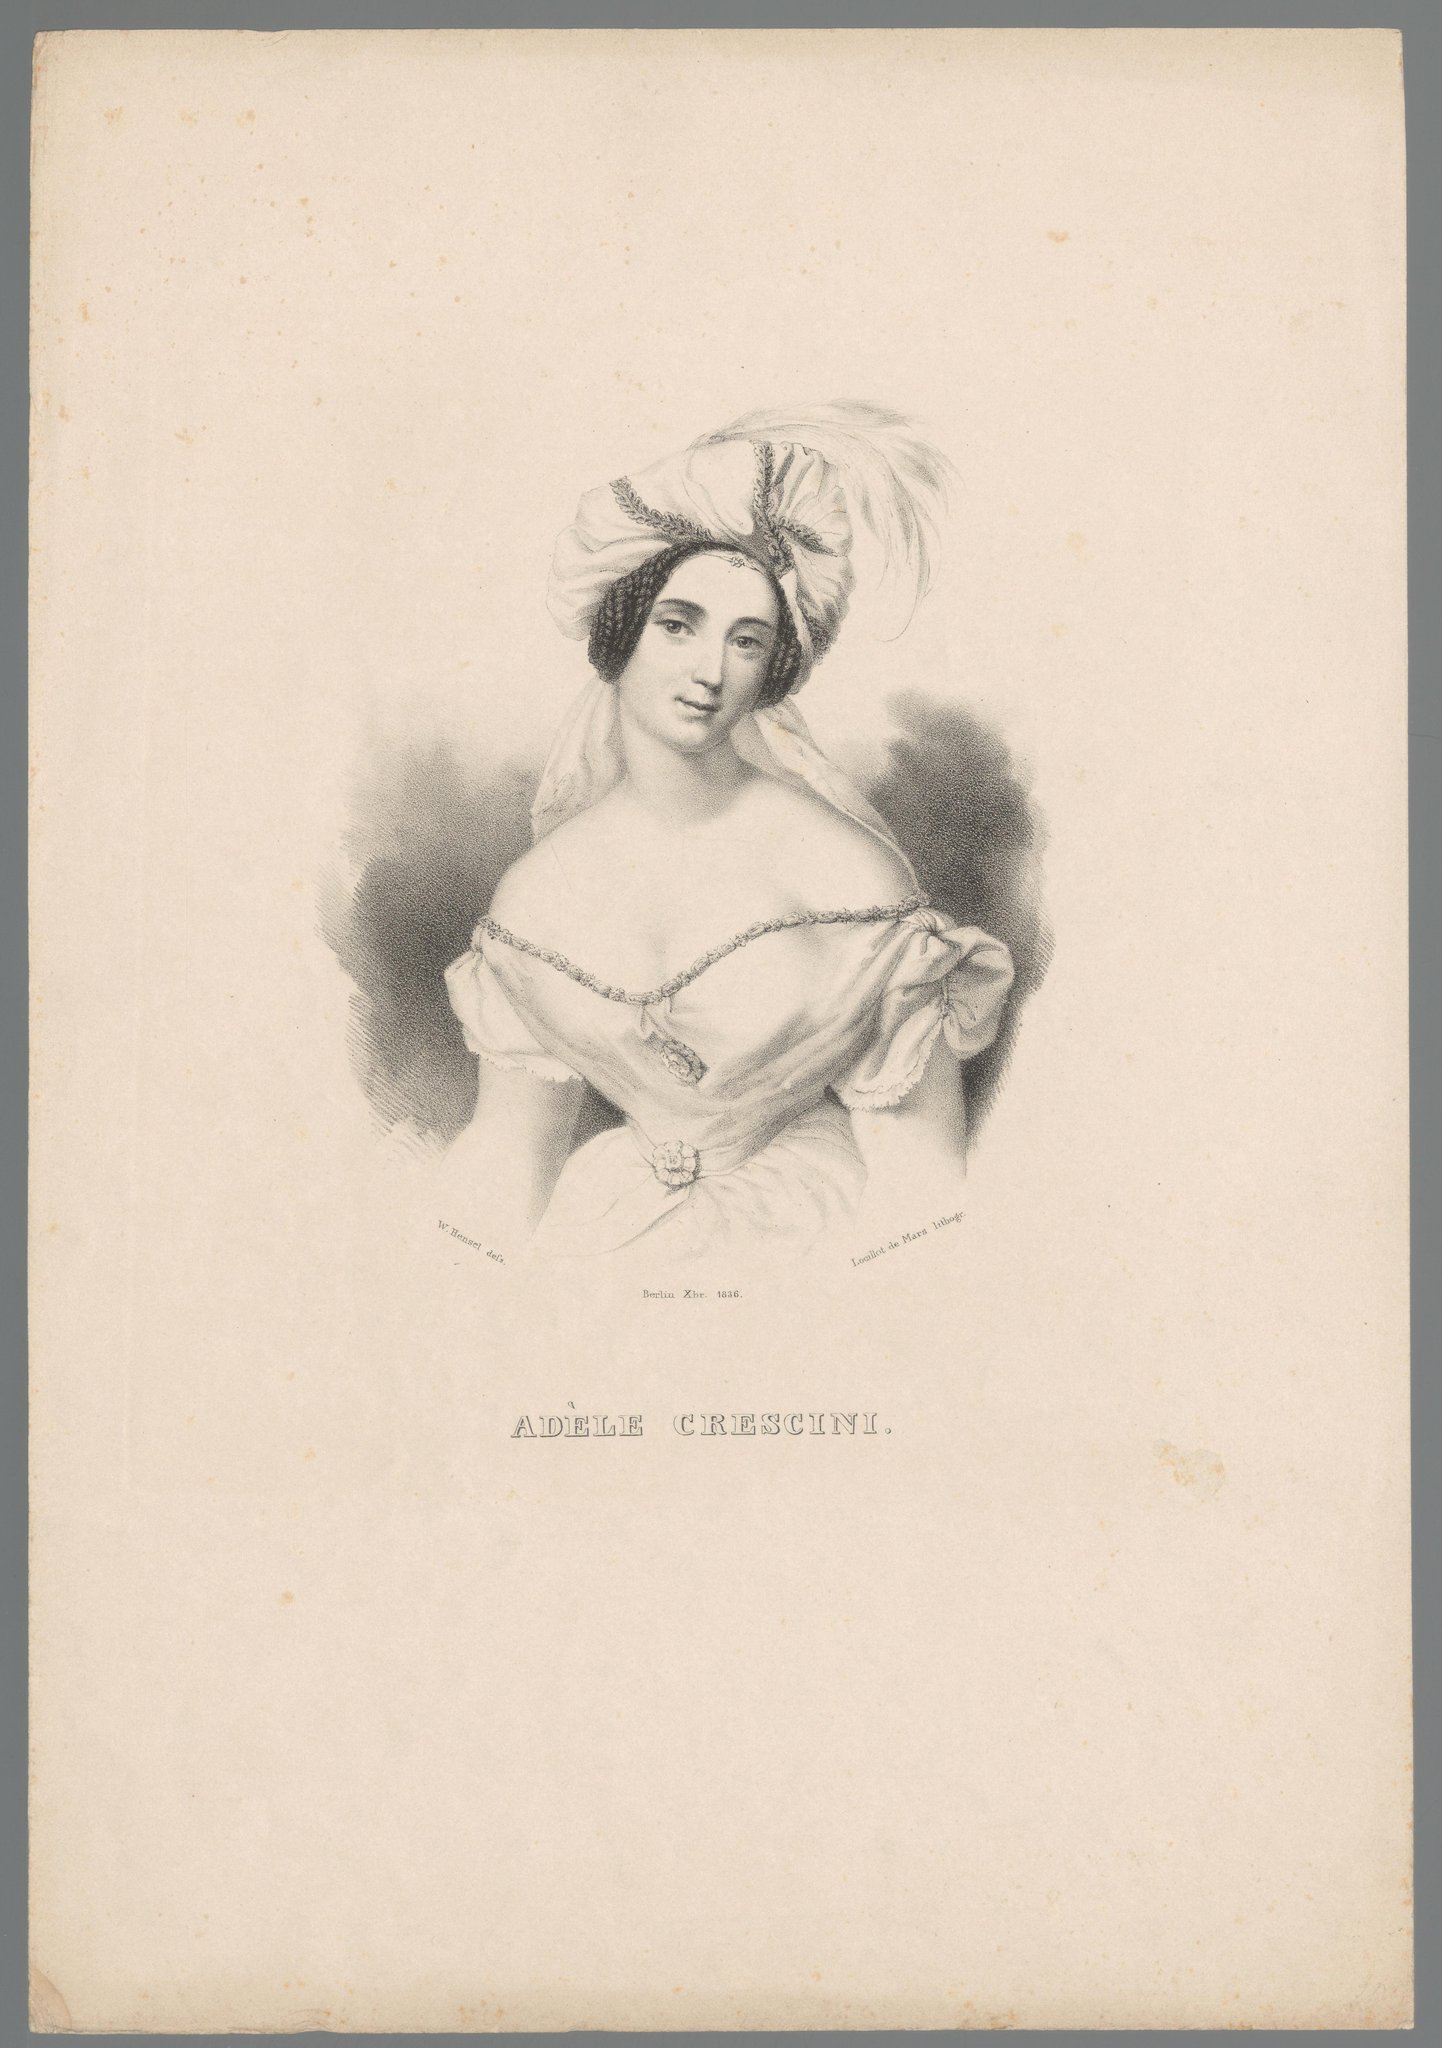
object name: print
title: Portret van Adela Crescini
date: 1836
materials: paper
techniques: lithograph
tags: venice, historical persons, portrait of opera-singer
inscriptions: collector's mark: Lugt 2228